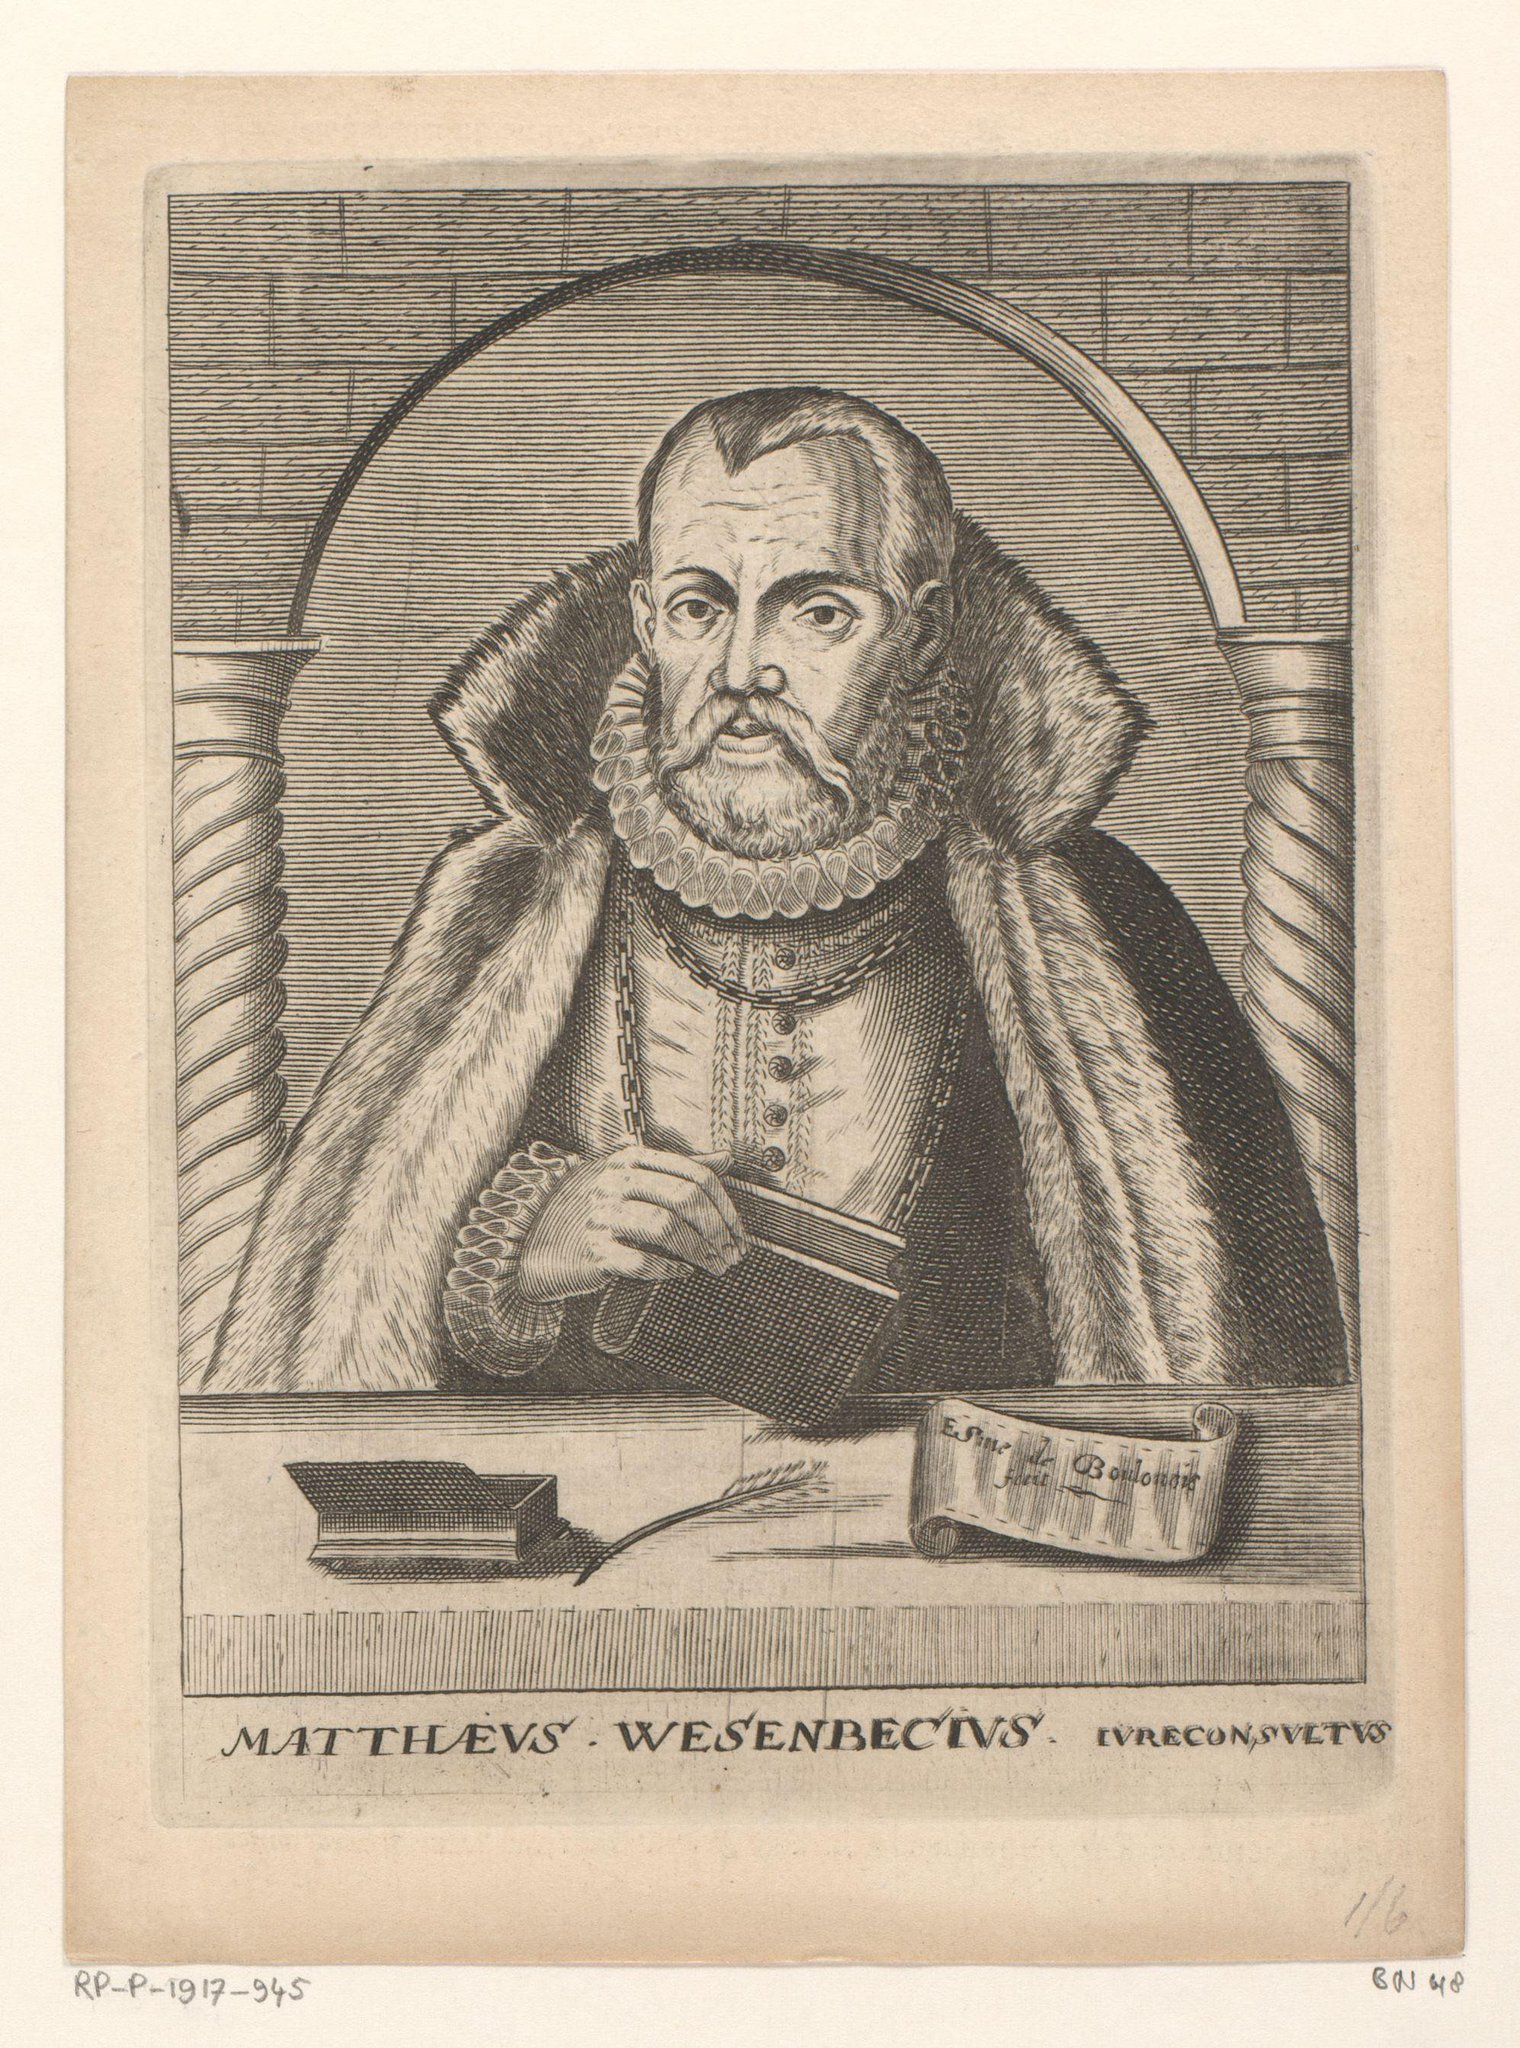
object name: print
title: Portret van Matthias Wesenbeck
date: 1682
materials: paper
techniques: engraving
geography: brussels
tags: antwerp, historical persons, administration of justice, trial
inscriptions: collector's mark: Lugt 2228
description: Prent uit: Bullert, Isaac. Académie des Sciences et Arts contenant les vies et éloges his. des hommes illustres qui ont excellé en ces professions depuis environ quatre siècles. Brussel: Foppens, François, 1682. Het boek werd in 1682 eveneens in Amsterdam uitgegeven door de erfgenamen van Daniel Elzevier. Deze portretten dienen ter illustratie van de biografie van een kunstenaar of geleerde. De meeste portretten werden door Nicolas de Larmessin vervaardigd (162), 93 door De Boulonois en een derde door ongeïdentificeerde prentmakers. Dit betreft een illustratie op p. 239, deel I.